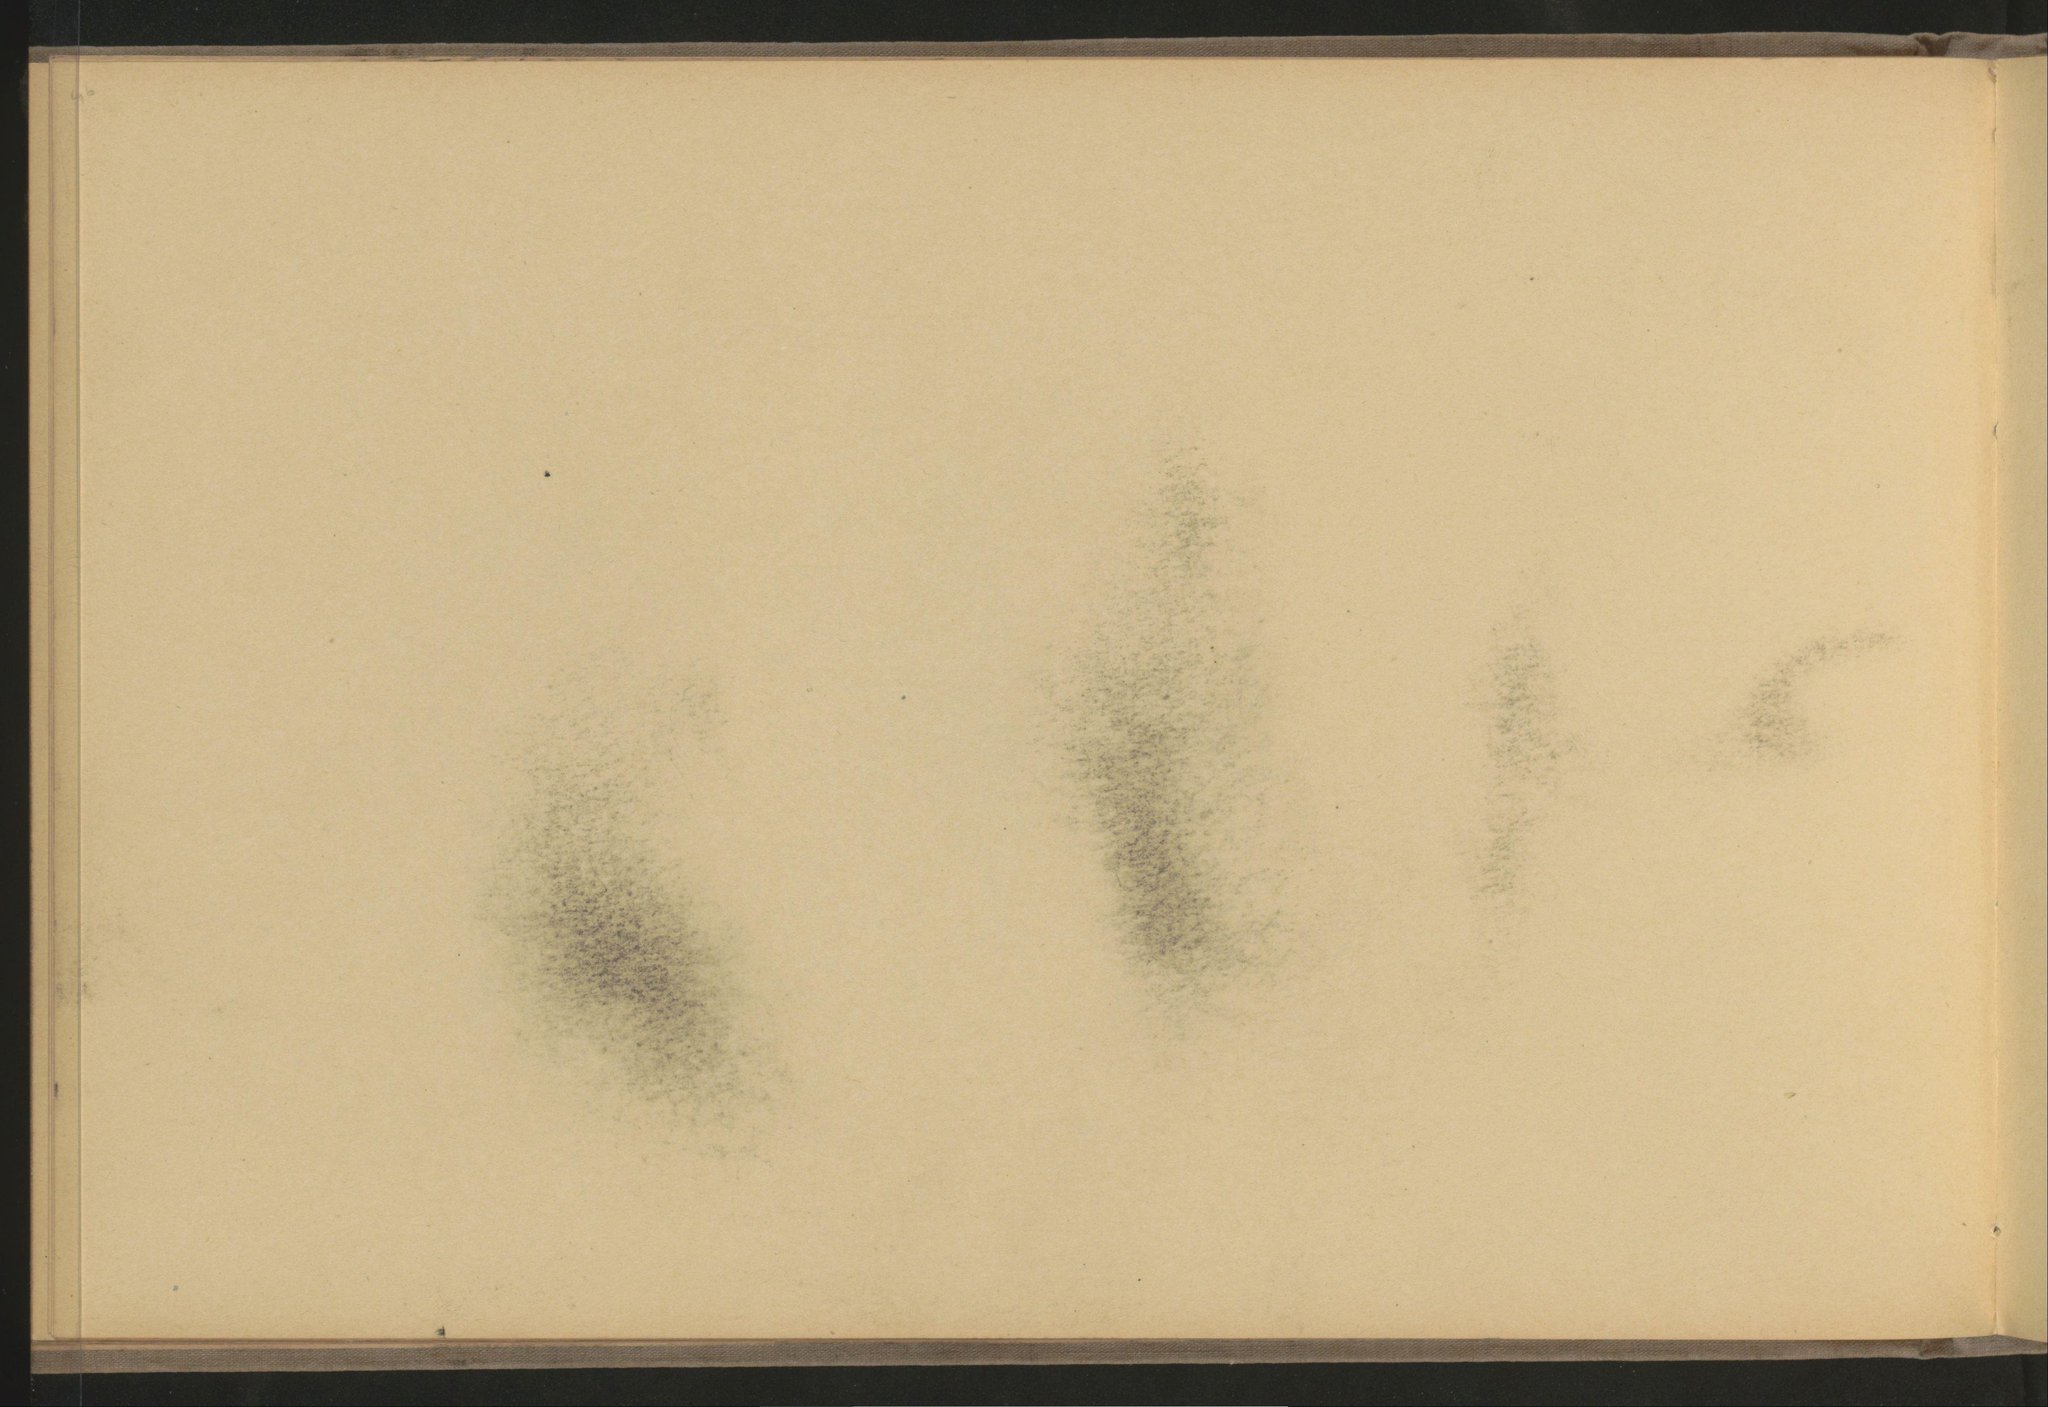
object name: sketchbook leaf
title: Abklatsch van een krijttekening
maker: willem witsen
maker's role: draughtsman, painter, print maker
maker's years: 1860-1923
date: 1901-1907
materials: paper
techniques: printmaking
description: Pagina 46 uit een schetsboek met 60 bladen.